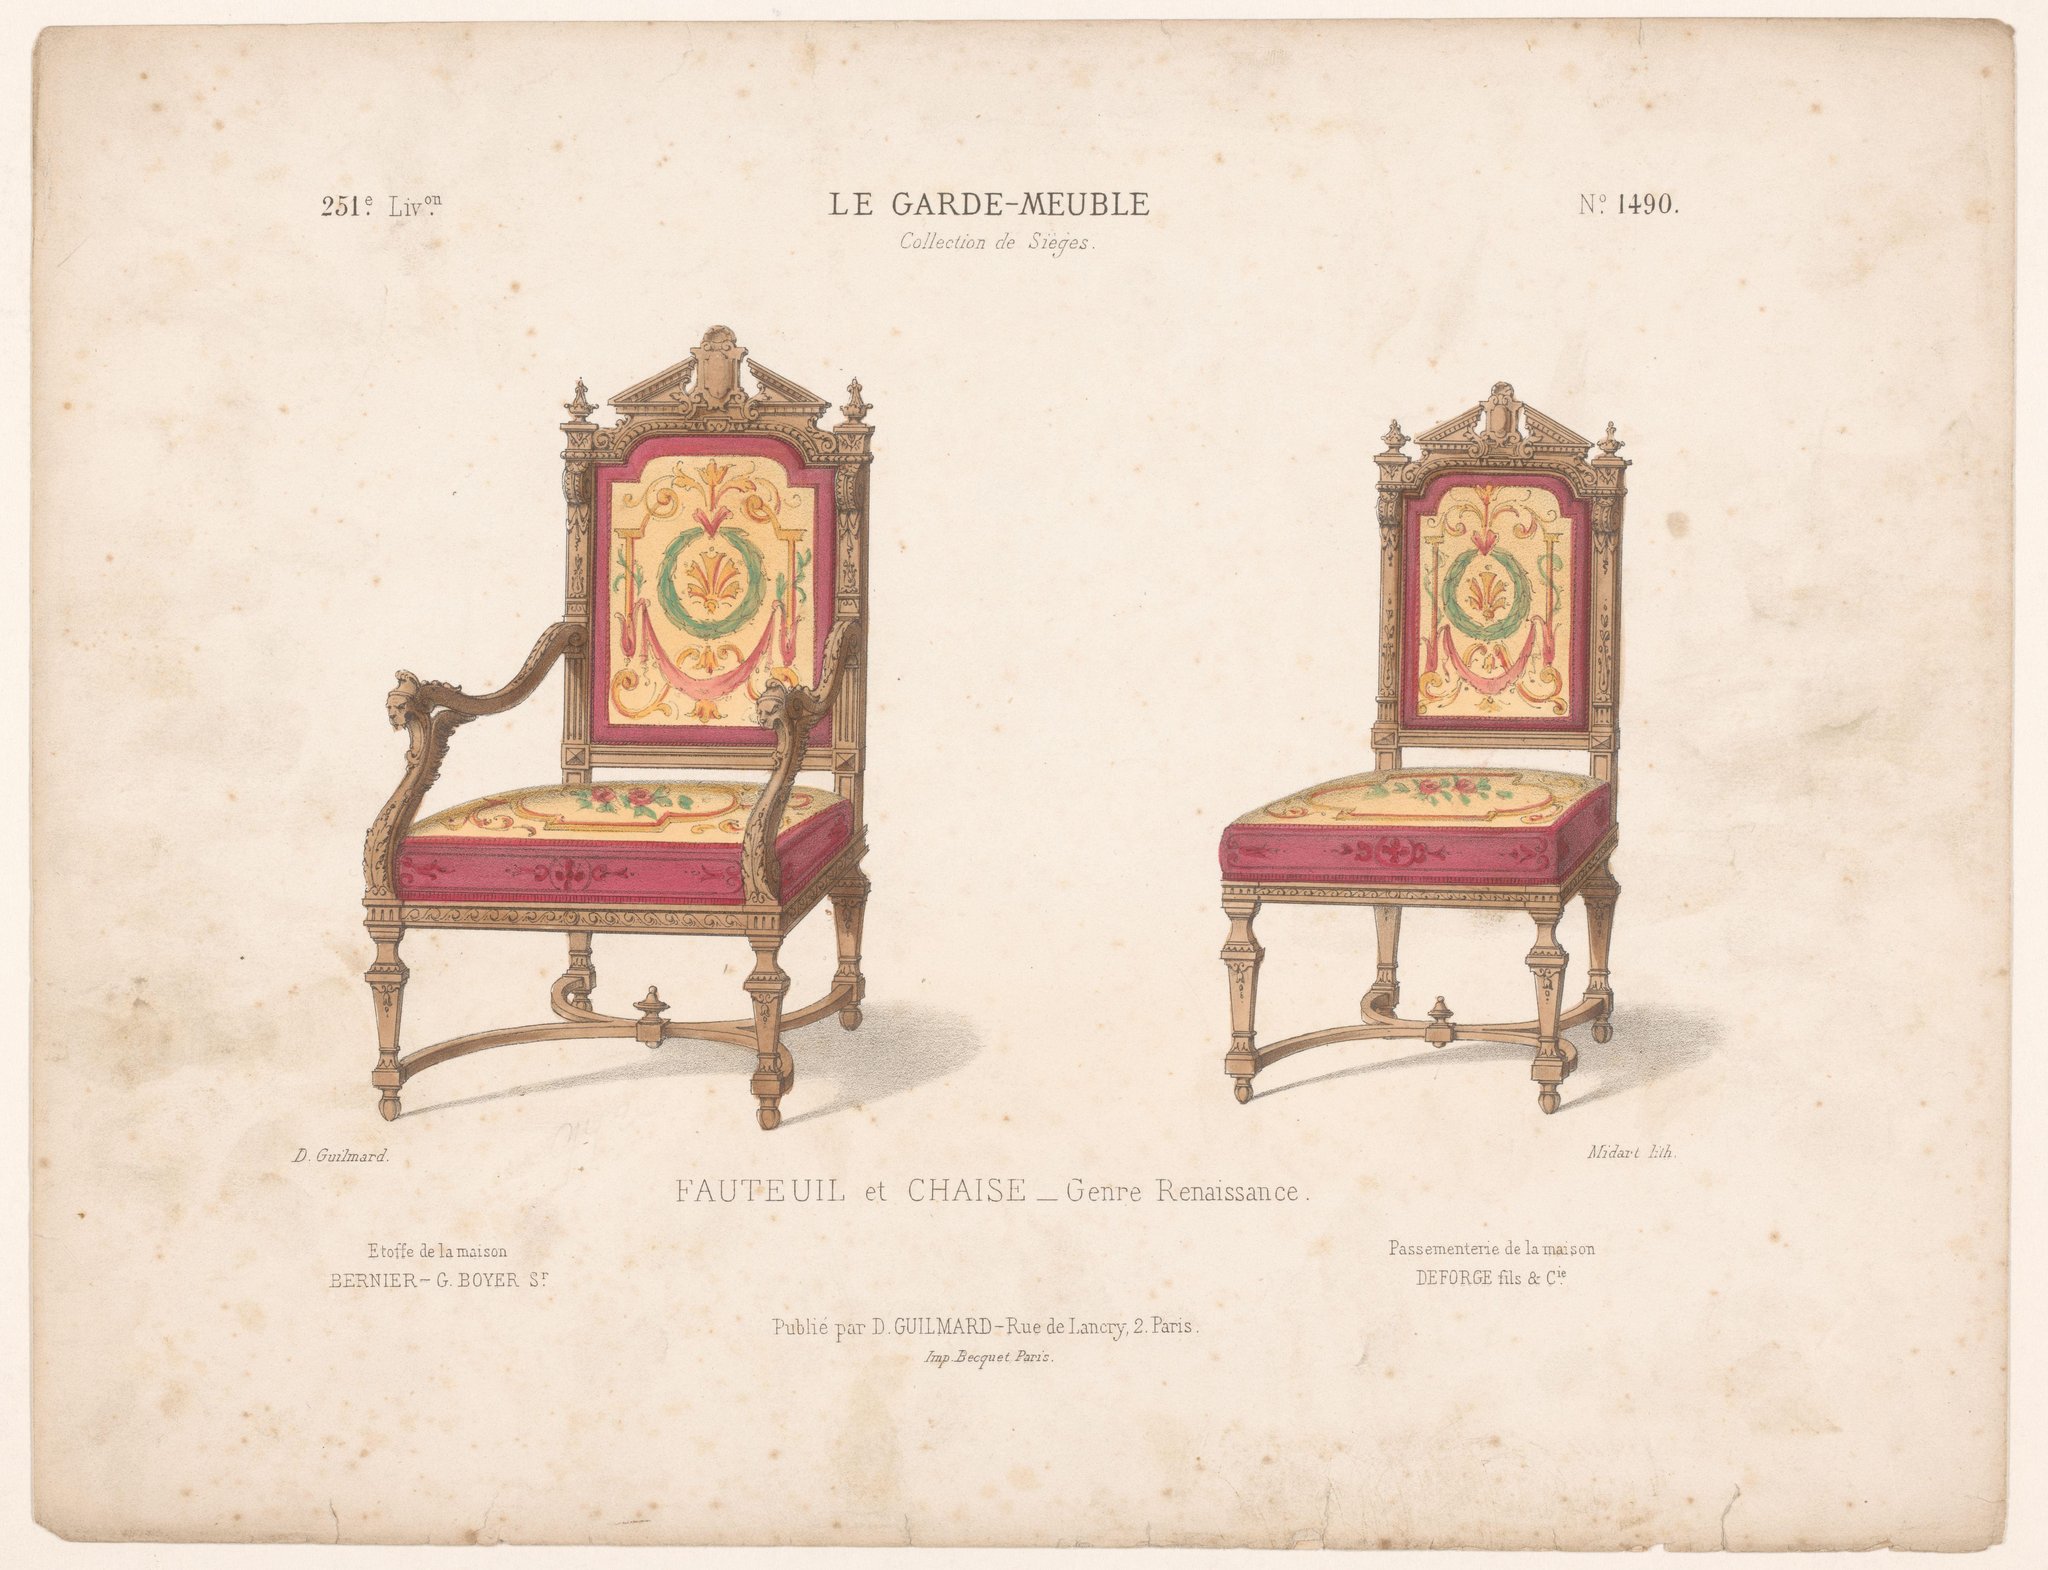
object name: print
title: Le garde-meuble / Collection de Sièges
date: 1839-1885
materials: paper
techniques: hand coloring, lithograph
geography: paris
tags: seating furniture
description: Ieder Livraison in de serie Le Garde-Meuble bevat negen platen: drie 'sièges' (zitmeubels), drie 'meubles' (diverse meubels zoals tafels en kasten) en drie 'tentures' (gordijnen en draperieën).